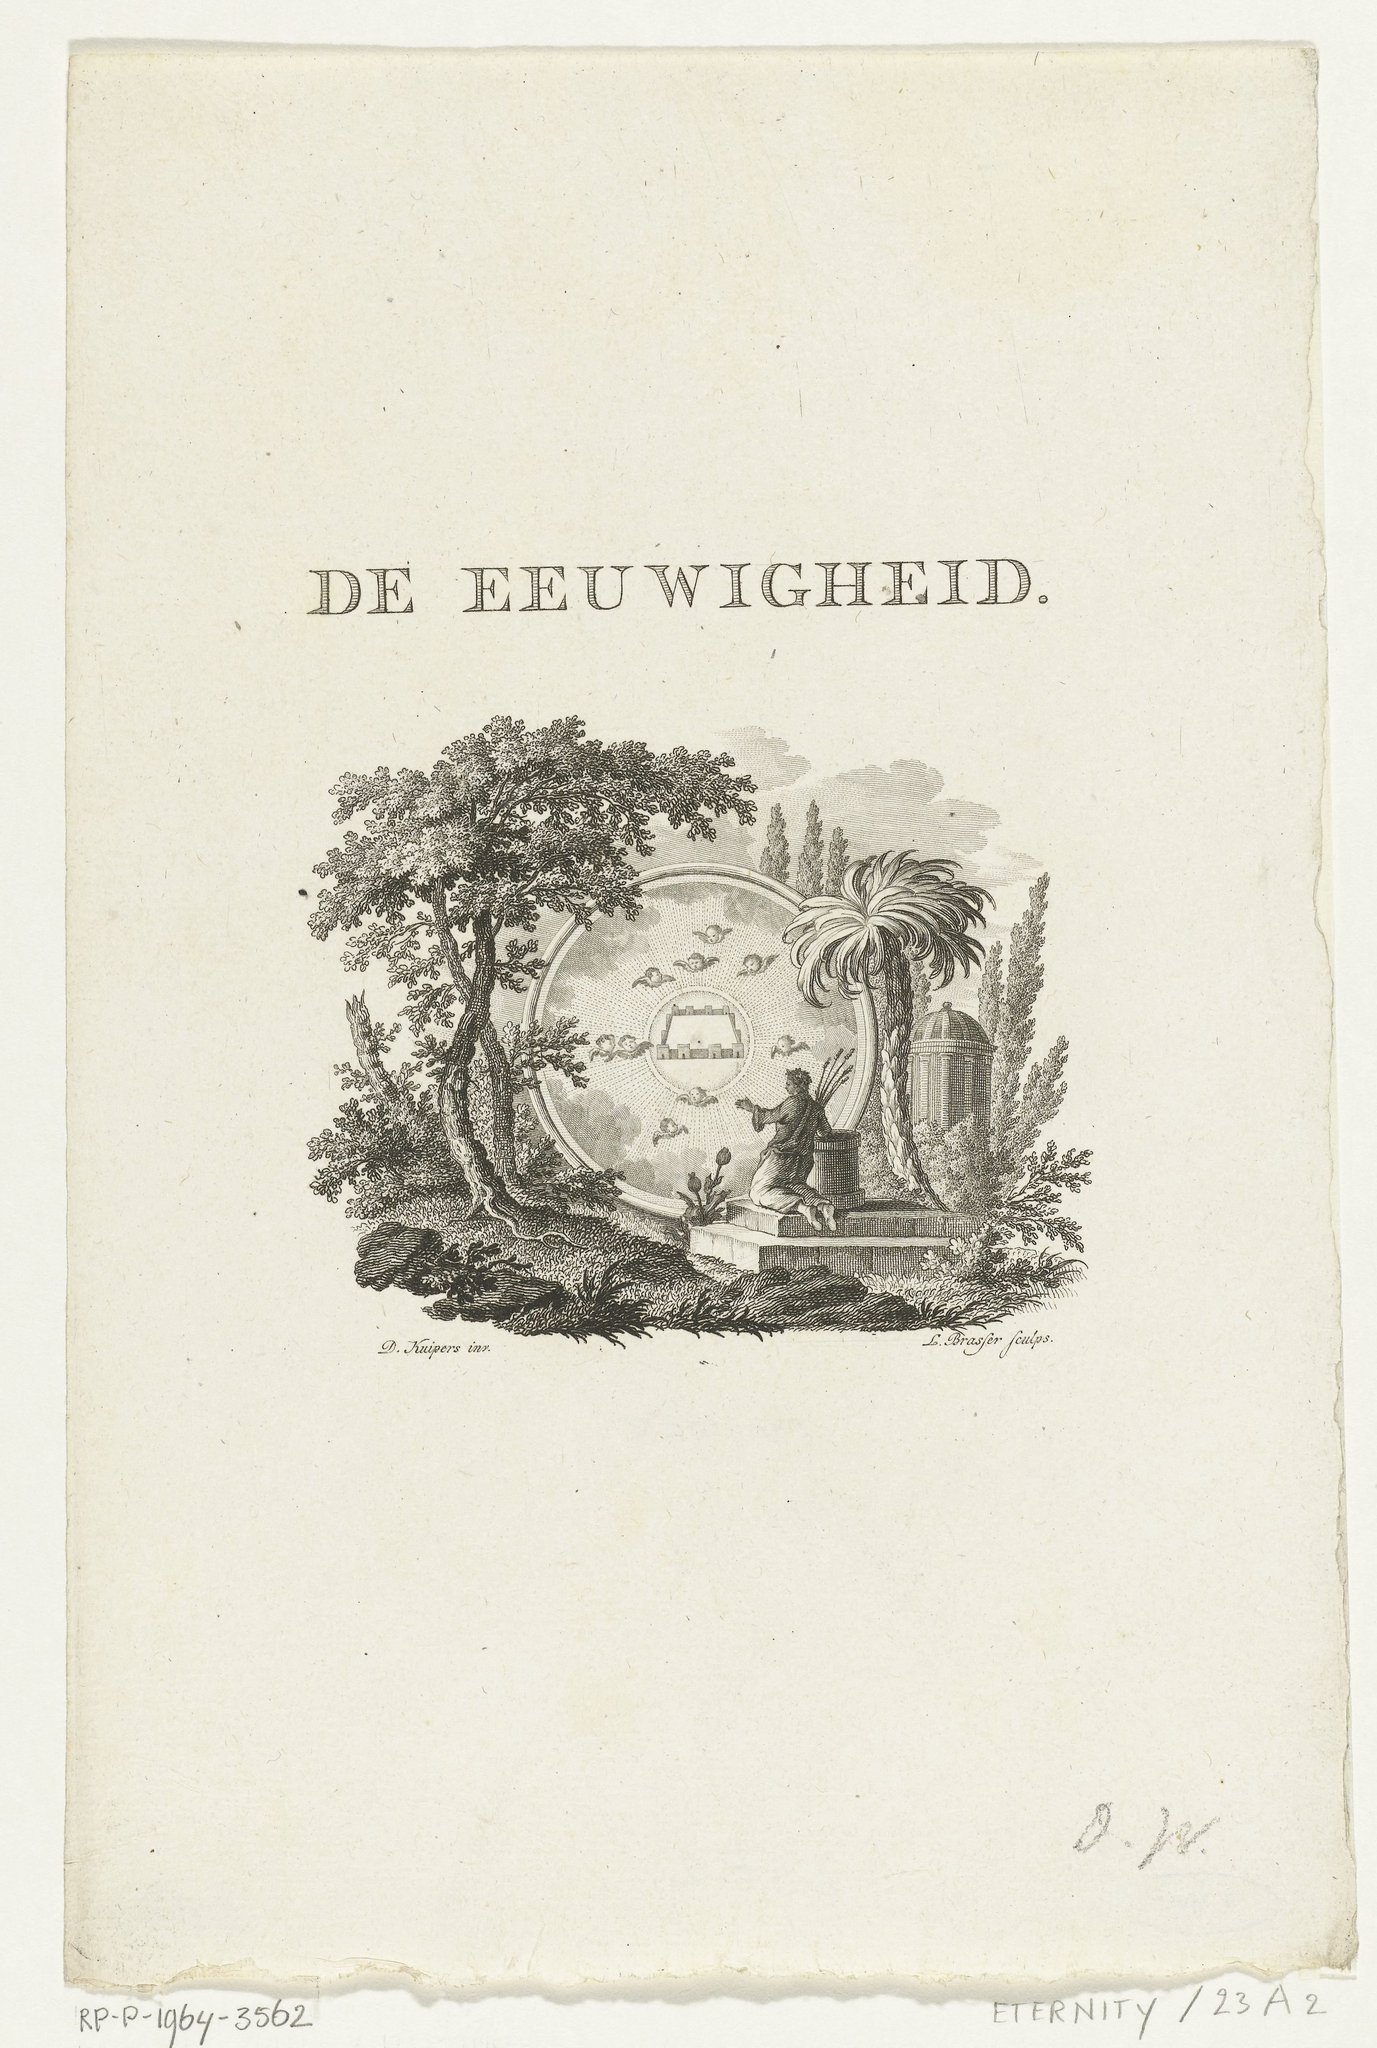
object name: print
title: Landschap met figuur die knielt voor visioen van Hemelse Jeruzalem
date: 1727-1793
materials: paper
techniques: engraving, etching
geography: netherlands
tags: eternity, 'aeternitas'; 'eternità','eternità o perpetuità' (ripa), heaven represented as a city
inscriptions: collector's mark: Lugt 2228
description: In een parkachtig landschap met een klein tempeltje of gramonument knielt een figuur met een bos korenaren voor een visioen van het Hemelse Jeruzalem, weergegeven als een medaillon met centraal een stadsmuur omgeven door lichtstralen en cherubijnen.